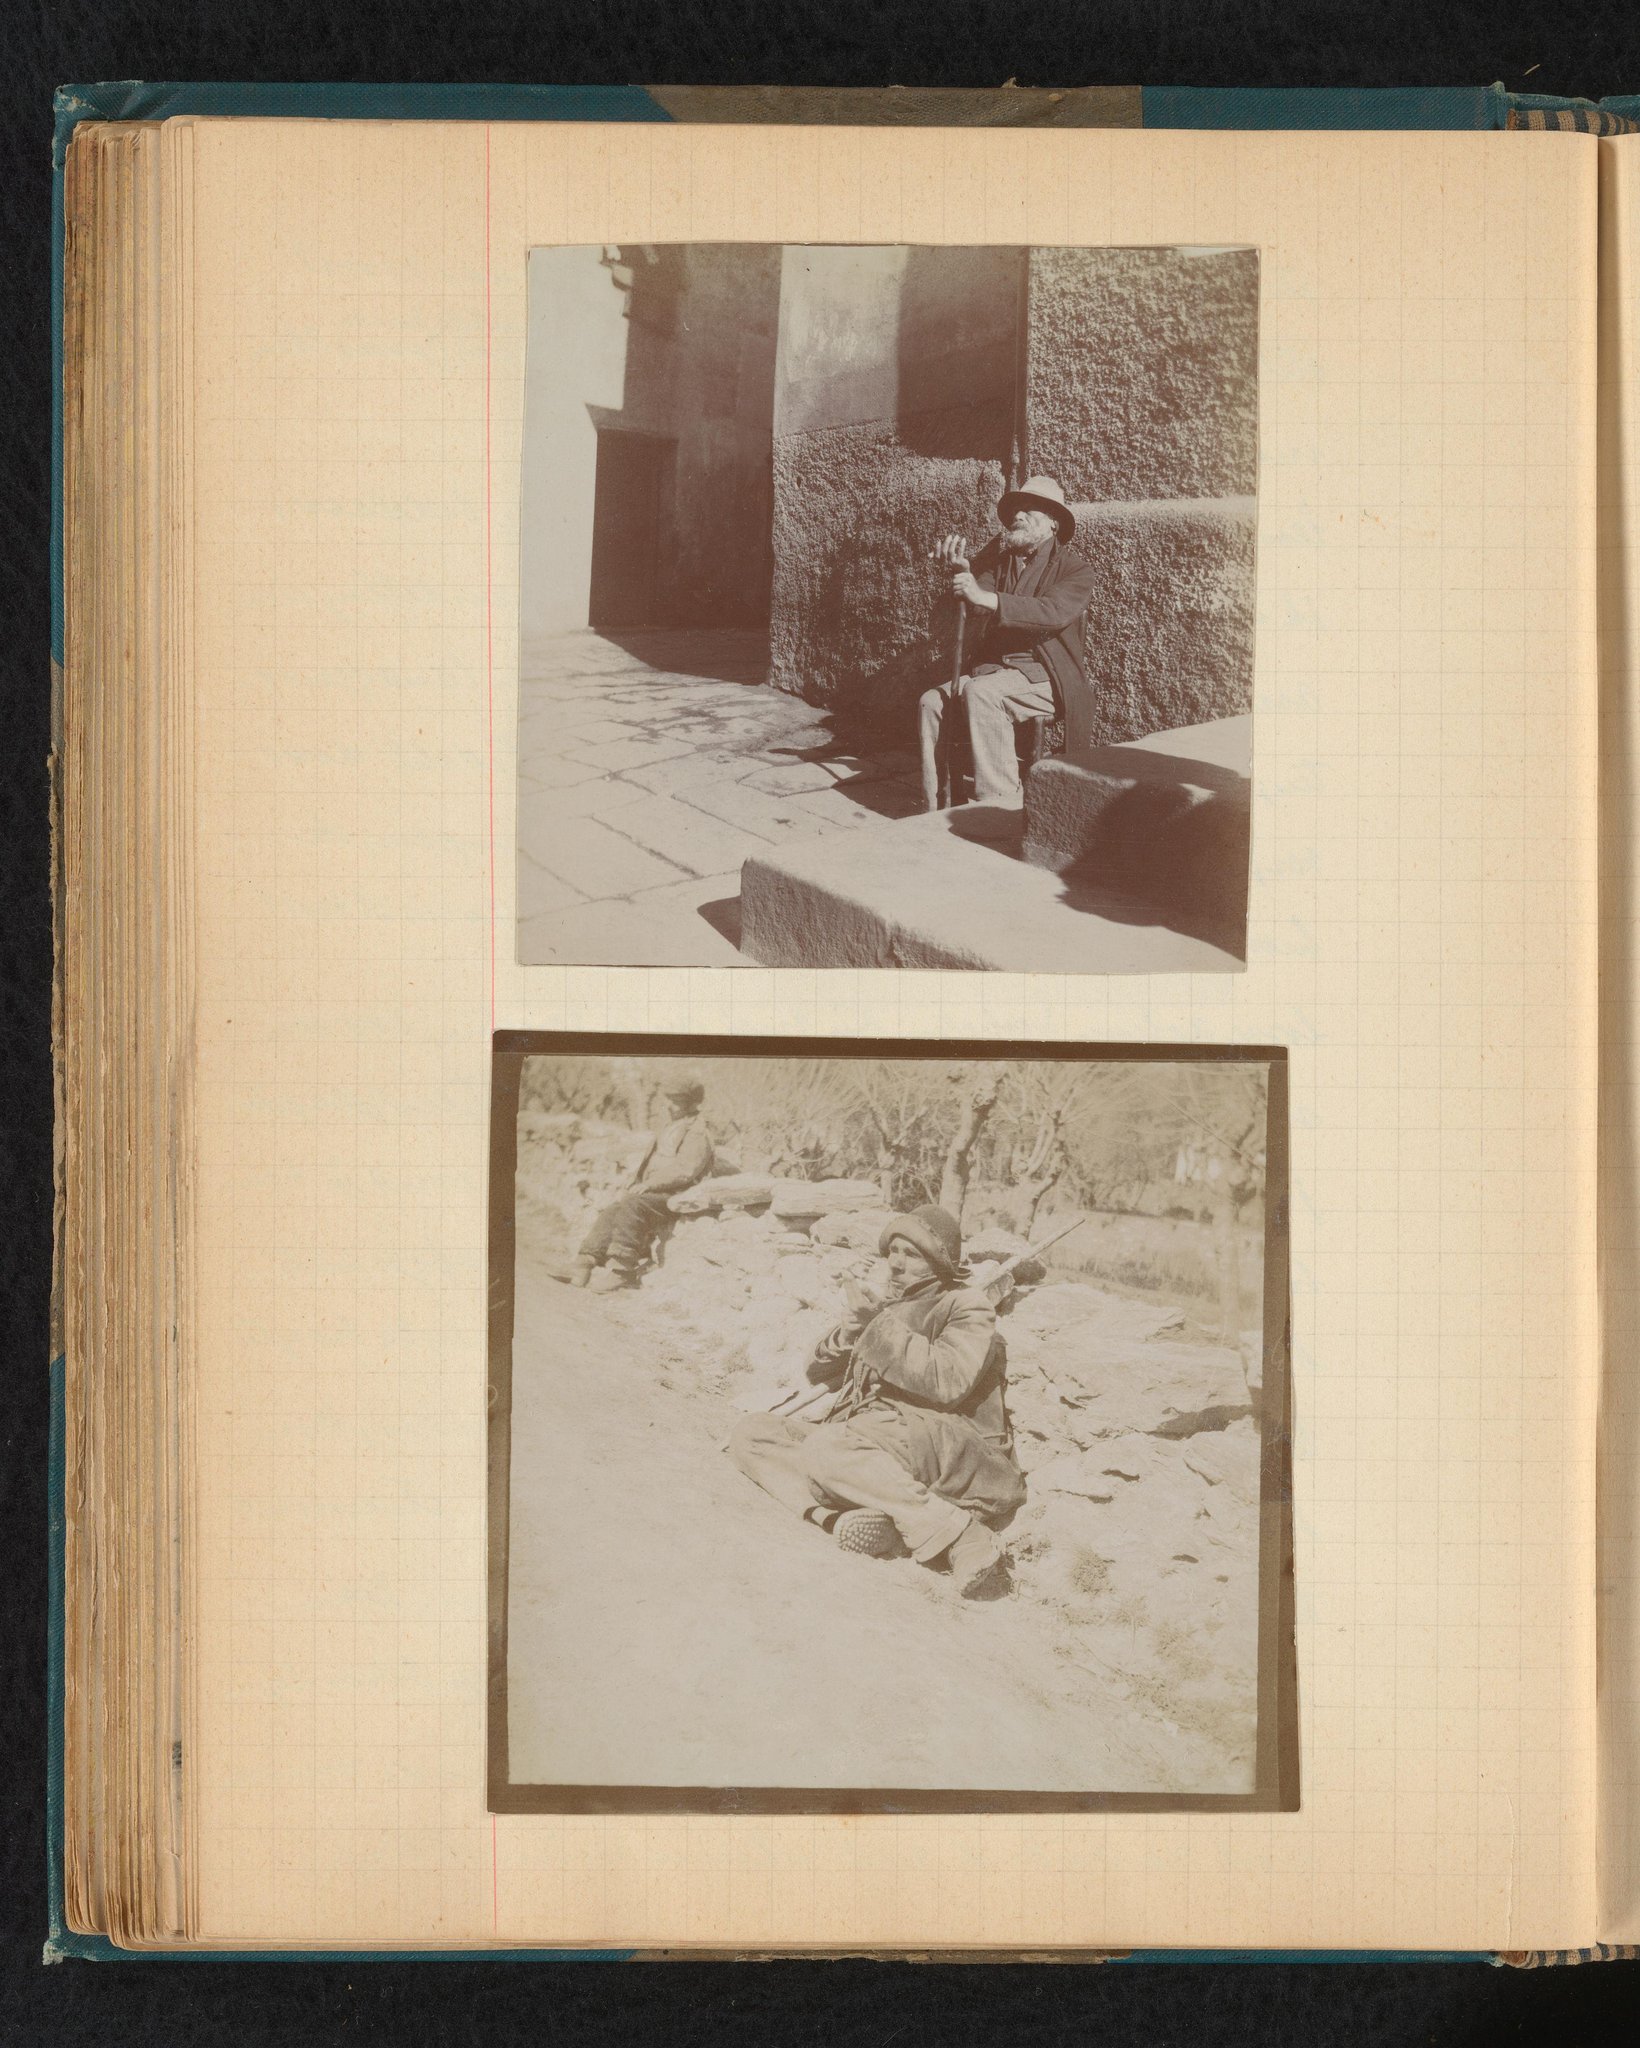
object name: album leaf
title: Onbekende mannen op straat met hoed en stok in Ajaccio, Corsica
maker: théodore van lelyveld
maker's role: painter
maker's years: 1867-1954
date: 1902-1904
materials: paper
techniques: gelatin silver print, daylight paper print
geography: ajaccio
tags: head-gear, old man, street, historical persons not known by name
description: Deze foto's maken deel uit van een album.